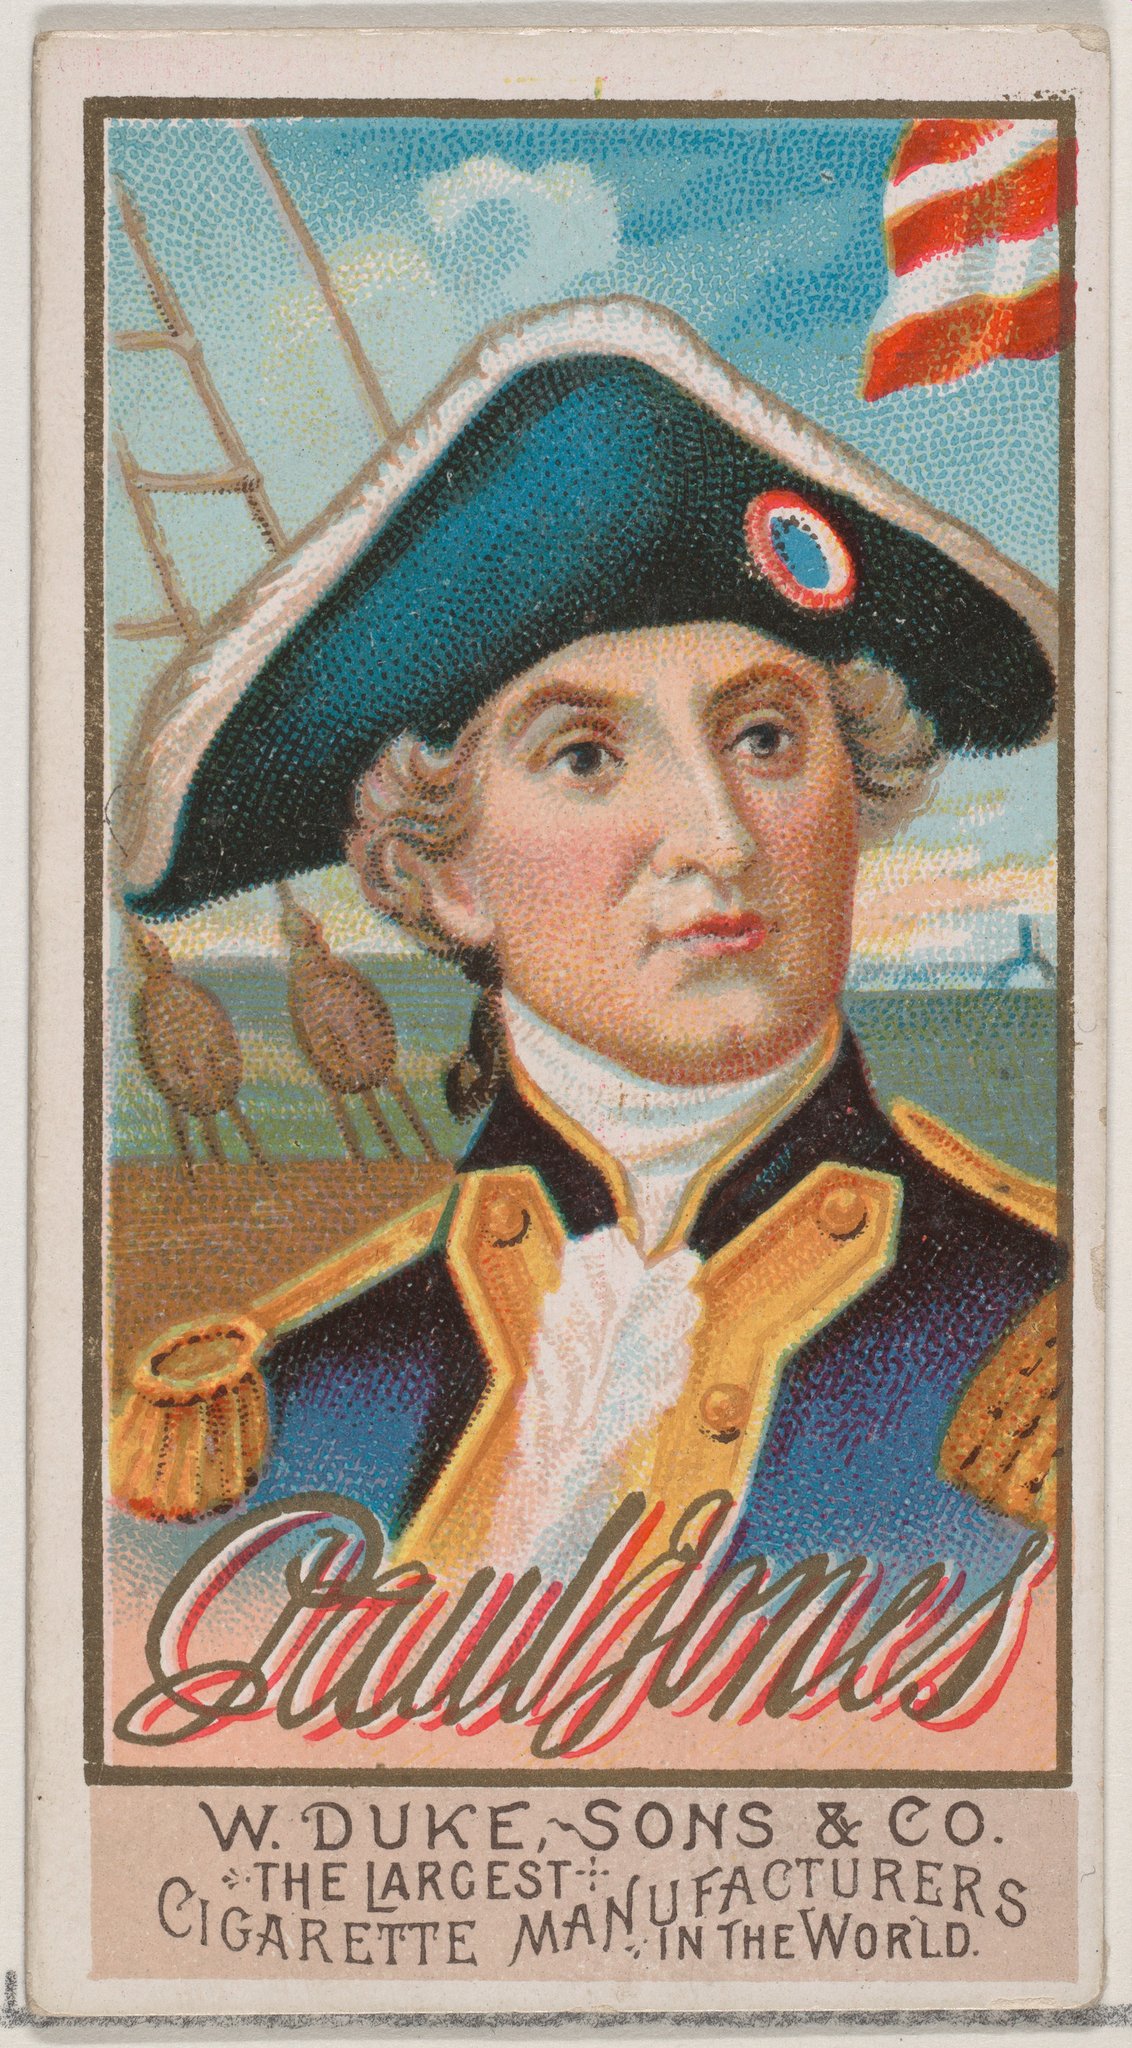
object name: print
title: Paul Jones, from the series Great Americans (N76) for Duke brand cigarettes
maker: w. duke, sons & co.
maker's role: publisher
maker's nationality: american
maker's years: 1870-1920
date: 1888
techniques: color lithograph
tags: men